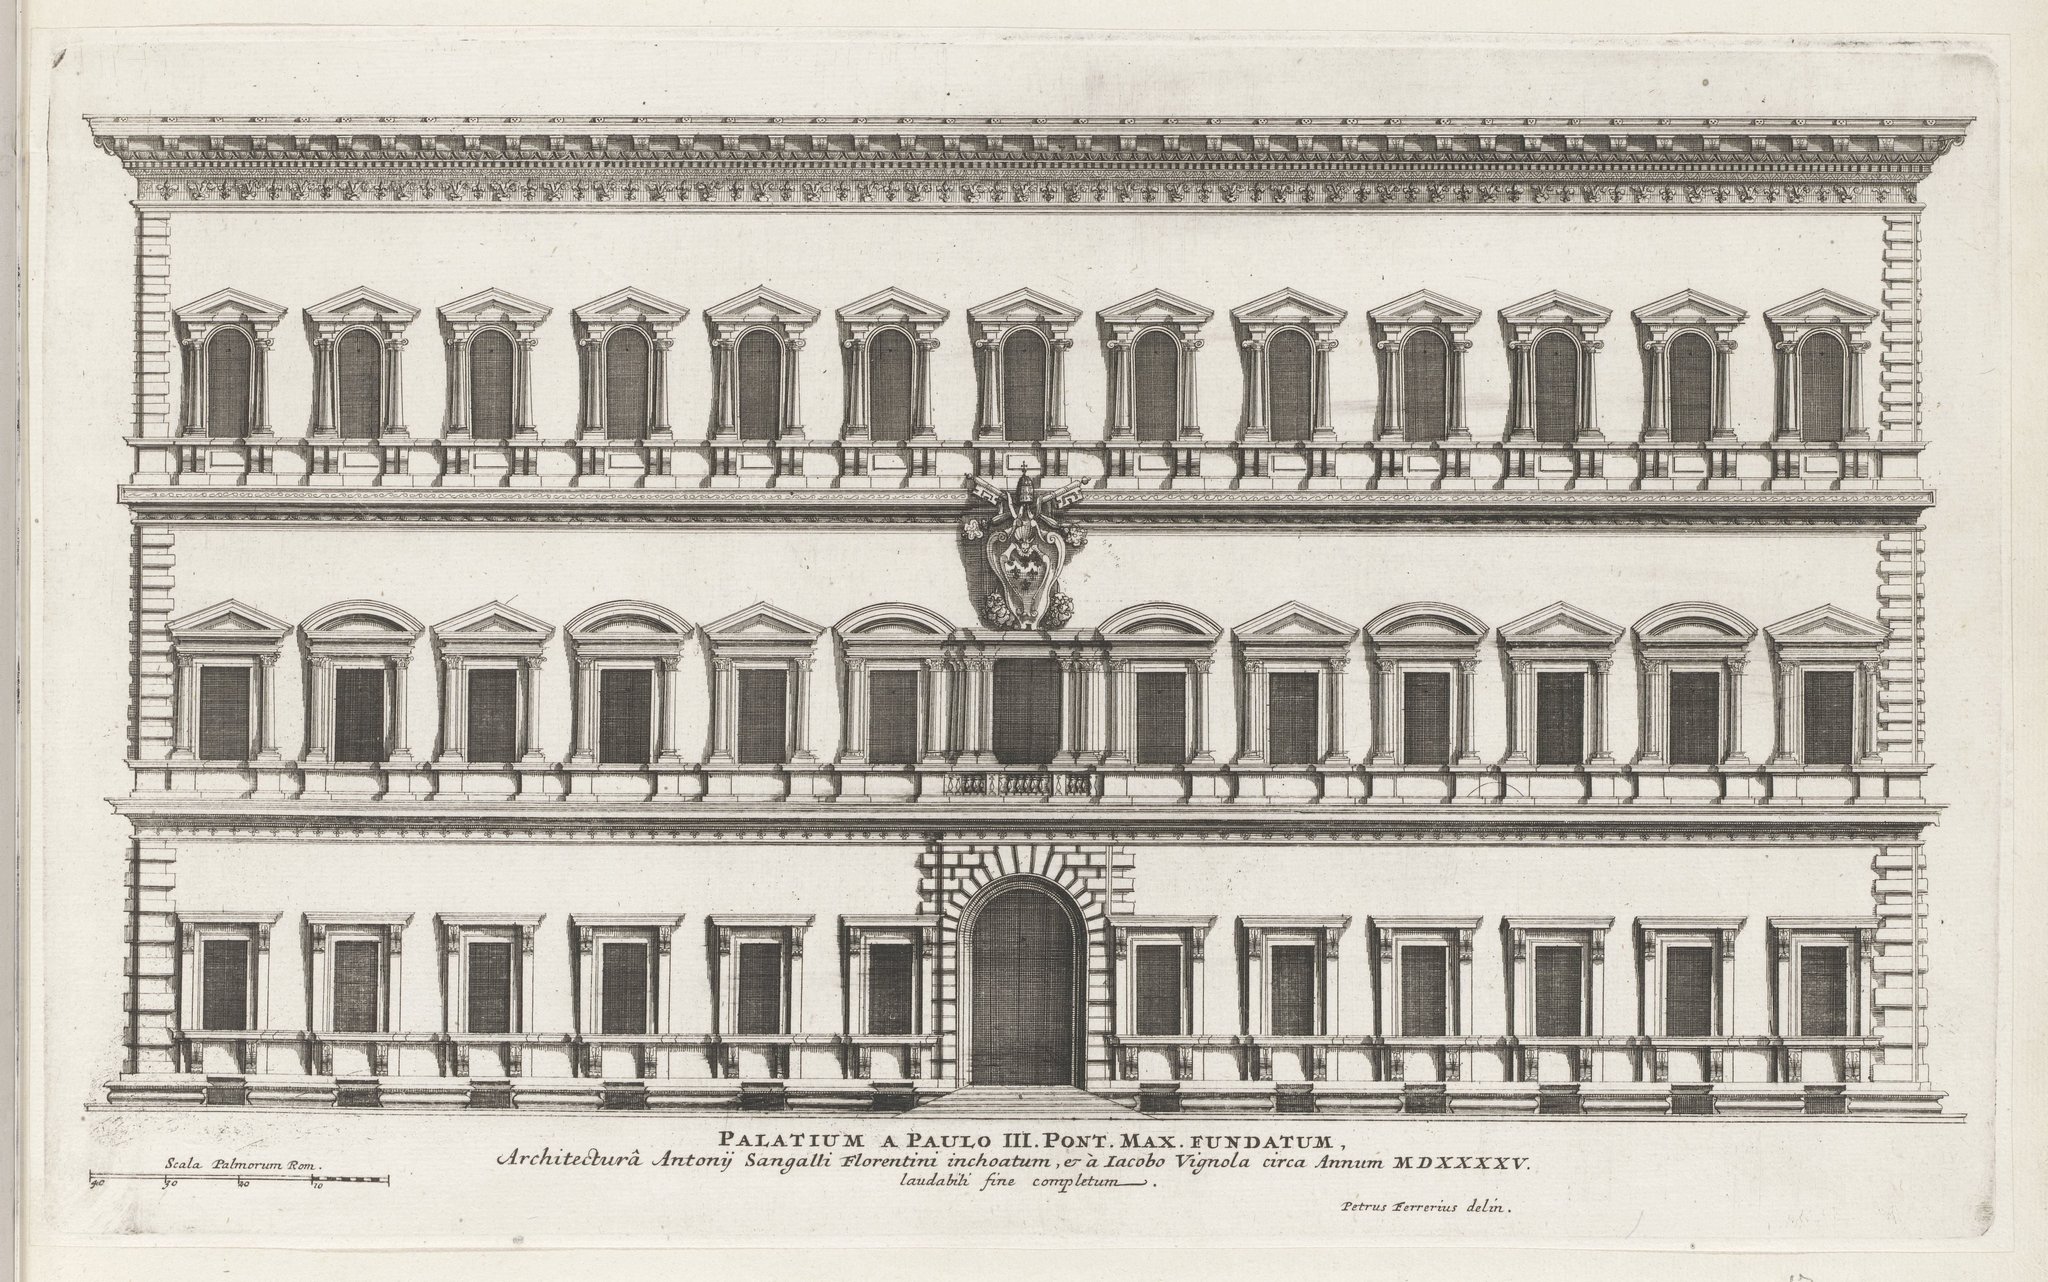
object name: album leaf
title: Magesyn der Italiaense gebouwen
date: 1655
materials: paper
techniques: etching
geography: italy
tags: rome, paulus iii, palace, façade (of house or building)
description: Deze prent maakt deel uit van de reeks getiteld: Palazzi di Roma. Deze reeks bestaat uit twee boeken. Boek één getiteld: Palazzi di Roma dei più celebri architetti..., bestaat uit 44 prenten die worden toegeschreven aan Giovanni Battista Falda (naam staat enkel op prent 27) en uitgegeven door Giovanni Giacomo de'Rossi. Deze 44 prenten zijn bekend in twee staten (met en zonder nummer). Boek twee getiteld: Nuovi disegni dell'architetture... libro secondo, bevat 66 prenten door Giovanni Battista Falda en Simone Felice. Deze 66 prenten zijn bekend in twee staten (met en zonder nummer).